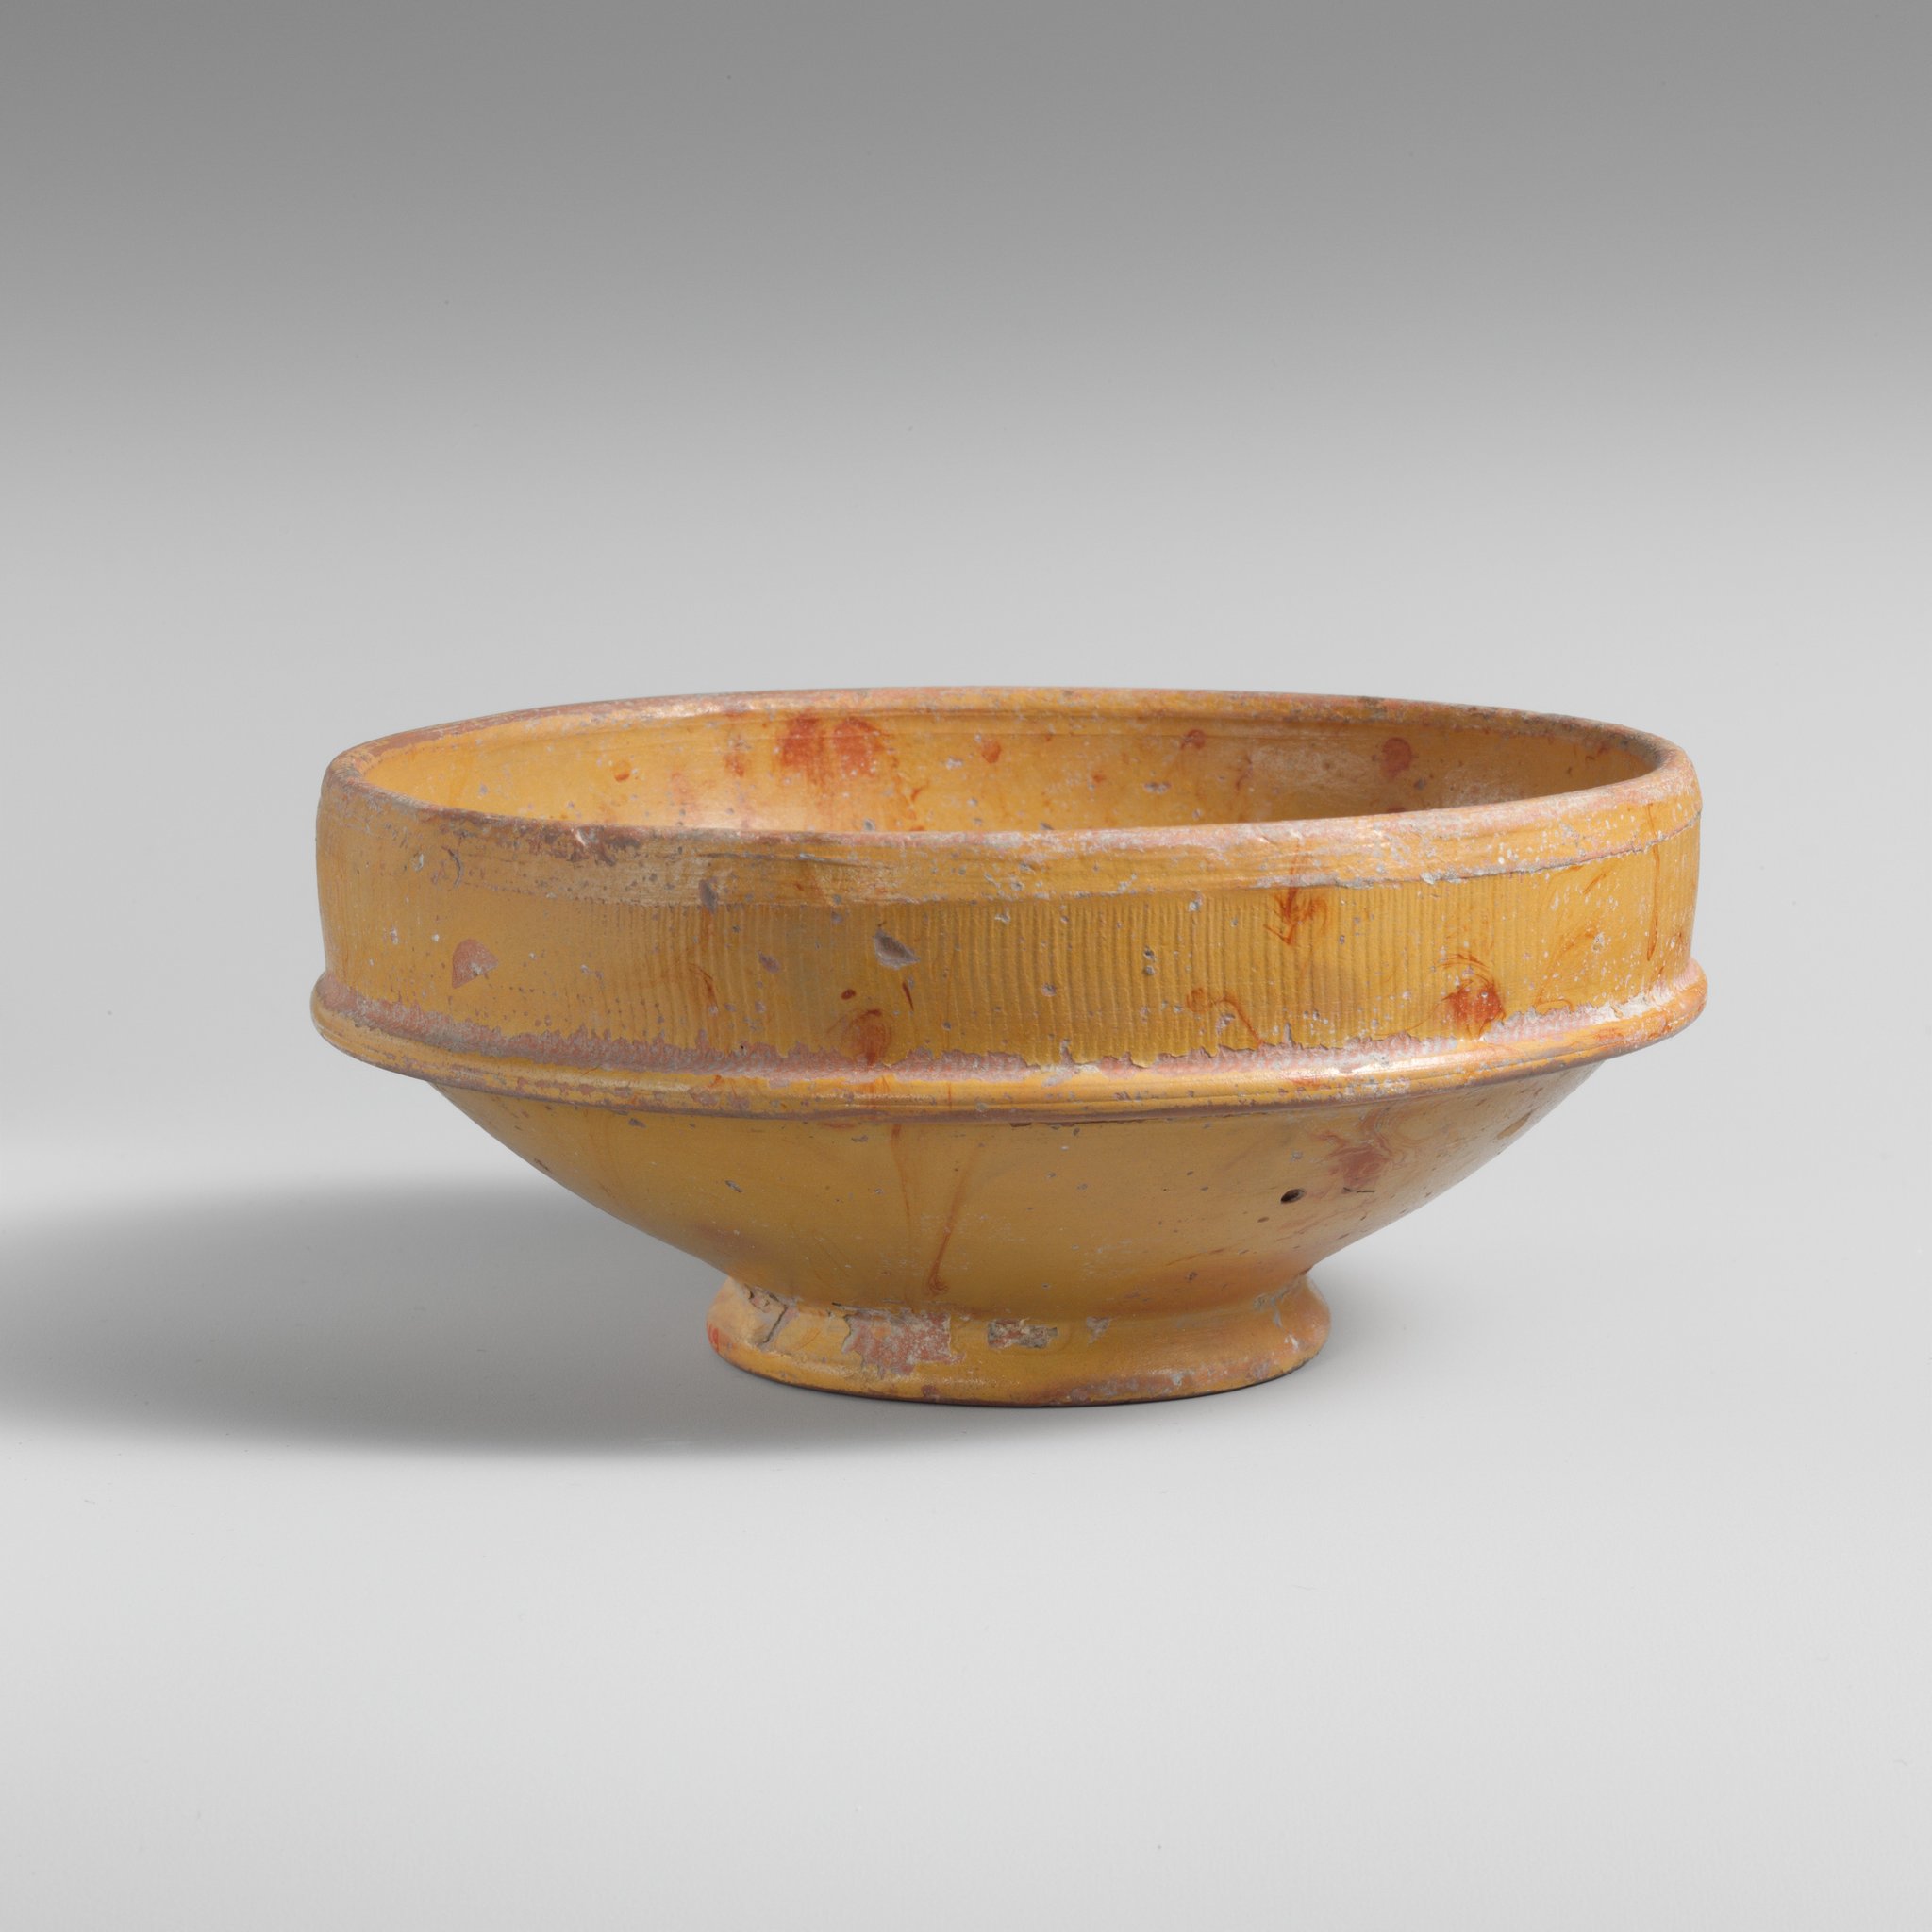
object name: bowl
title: Terracotta bowl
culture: roman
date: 34-66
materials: terracotta